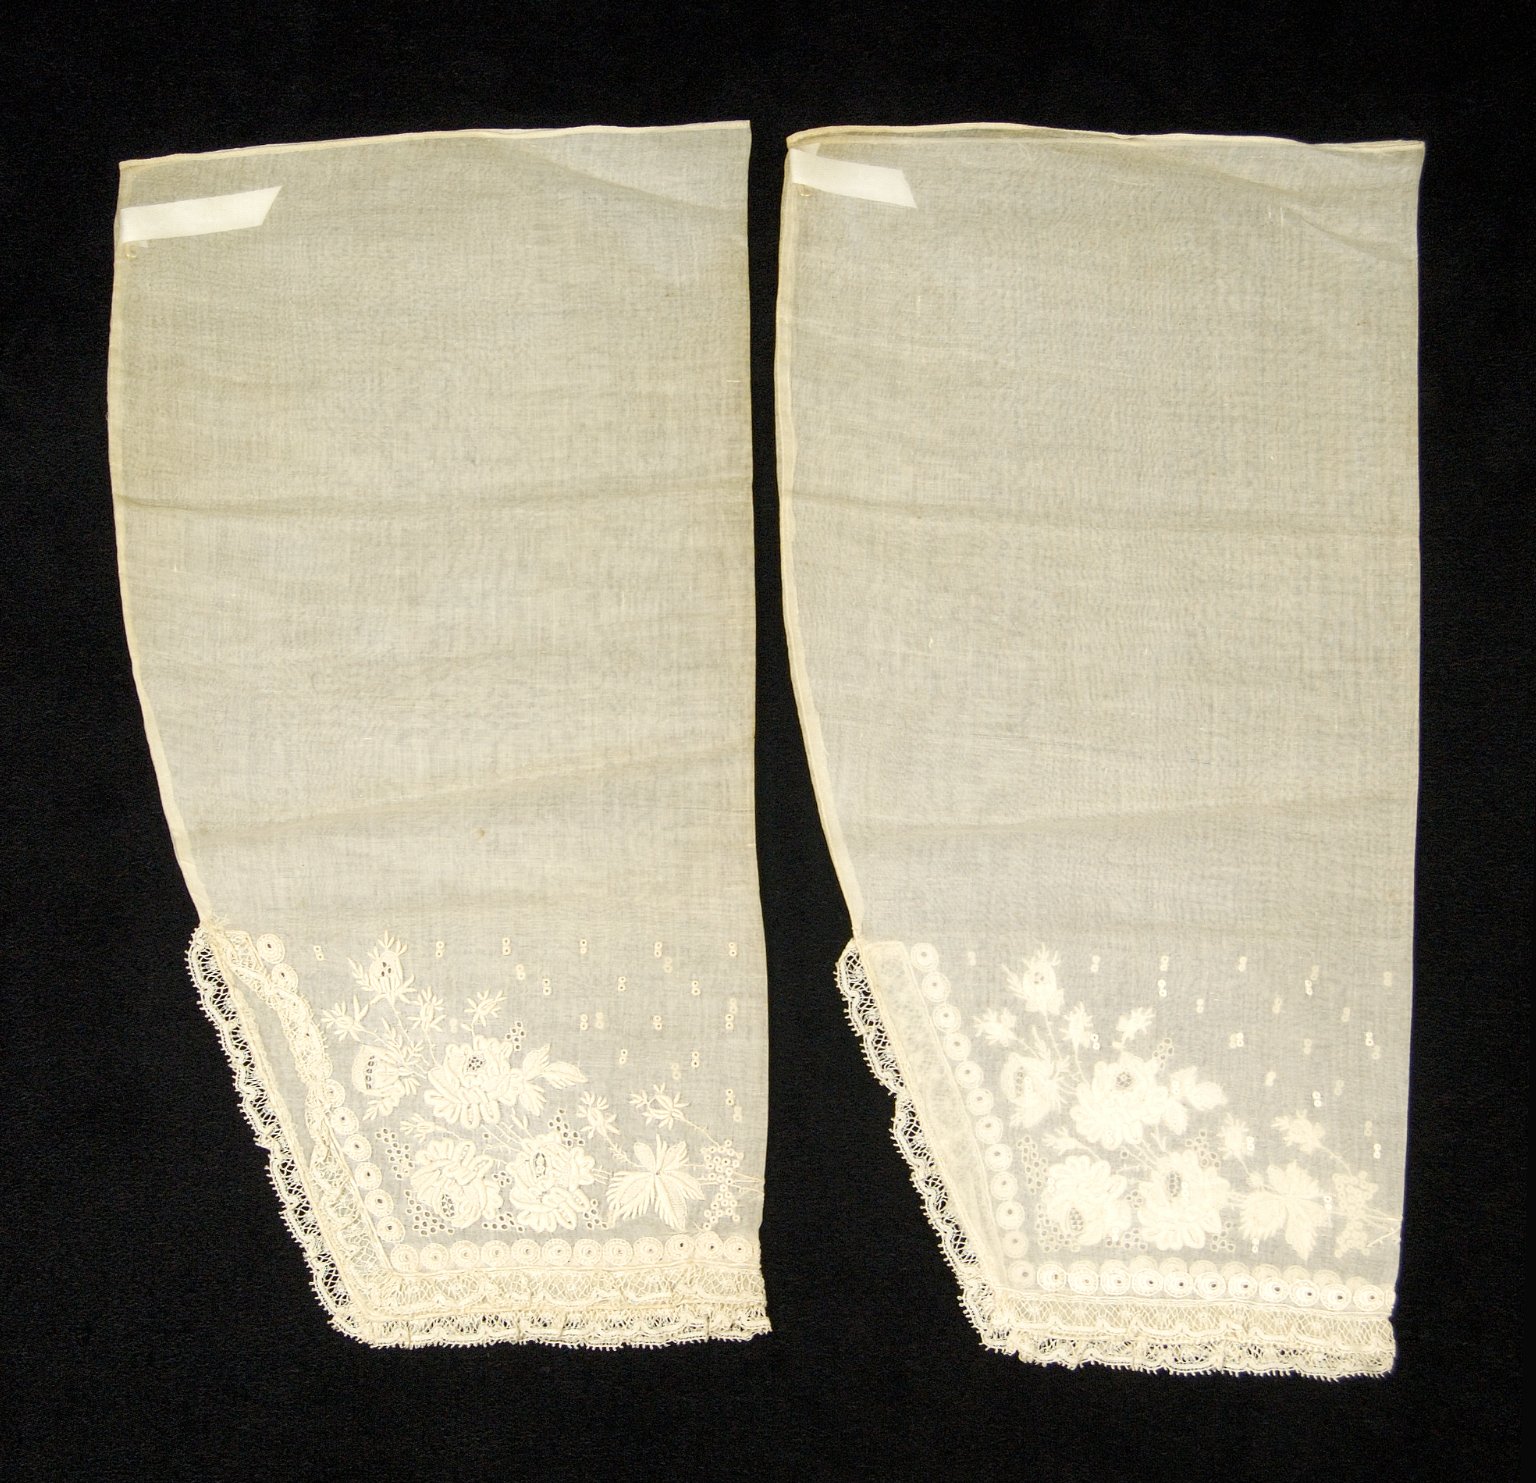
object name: undersleeves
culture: american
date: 1851-1875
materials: cotton